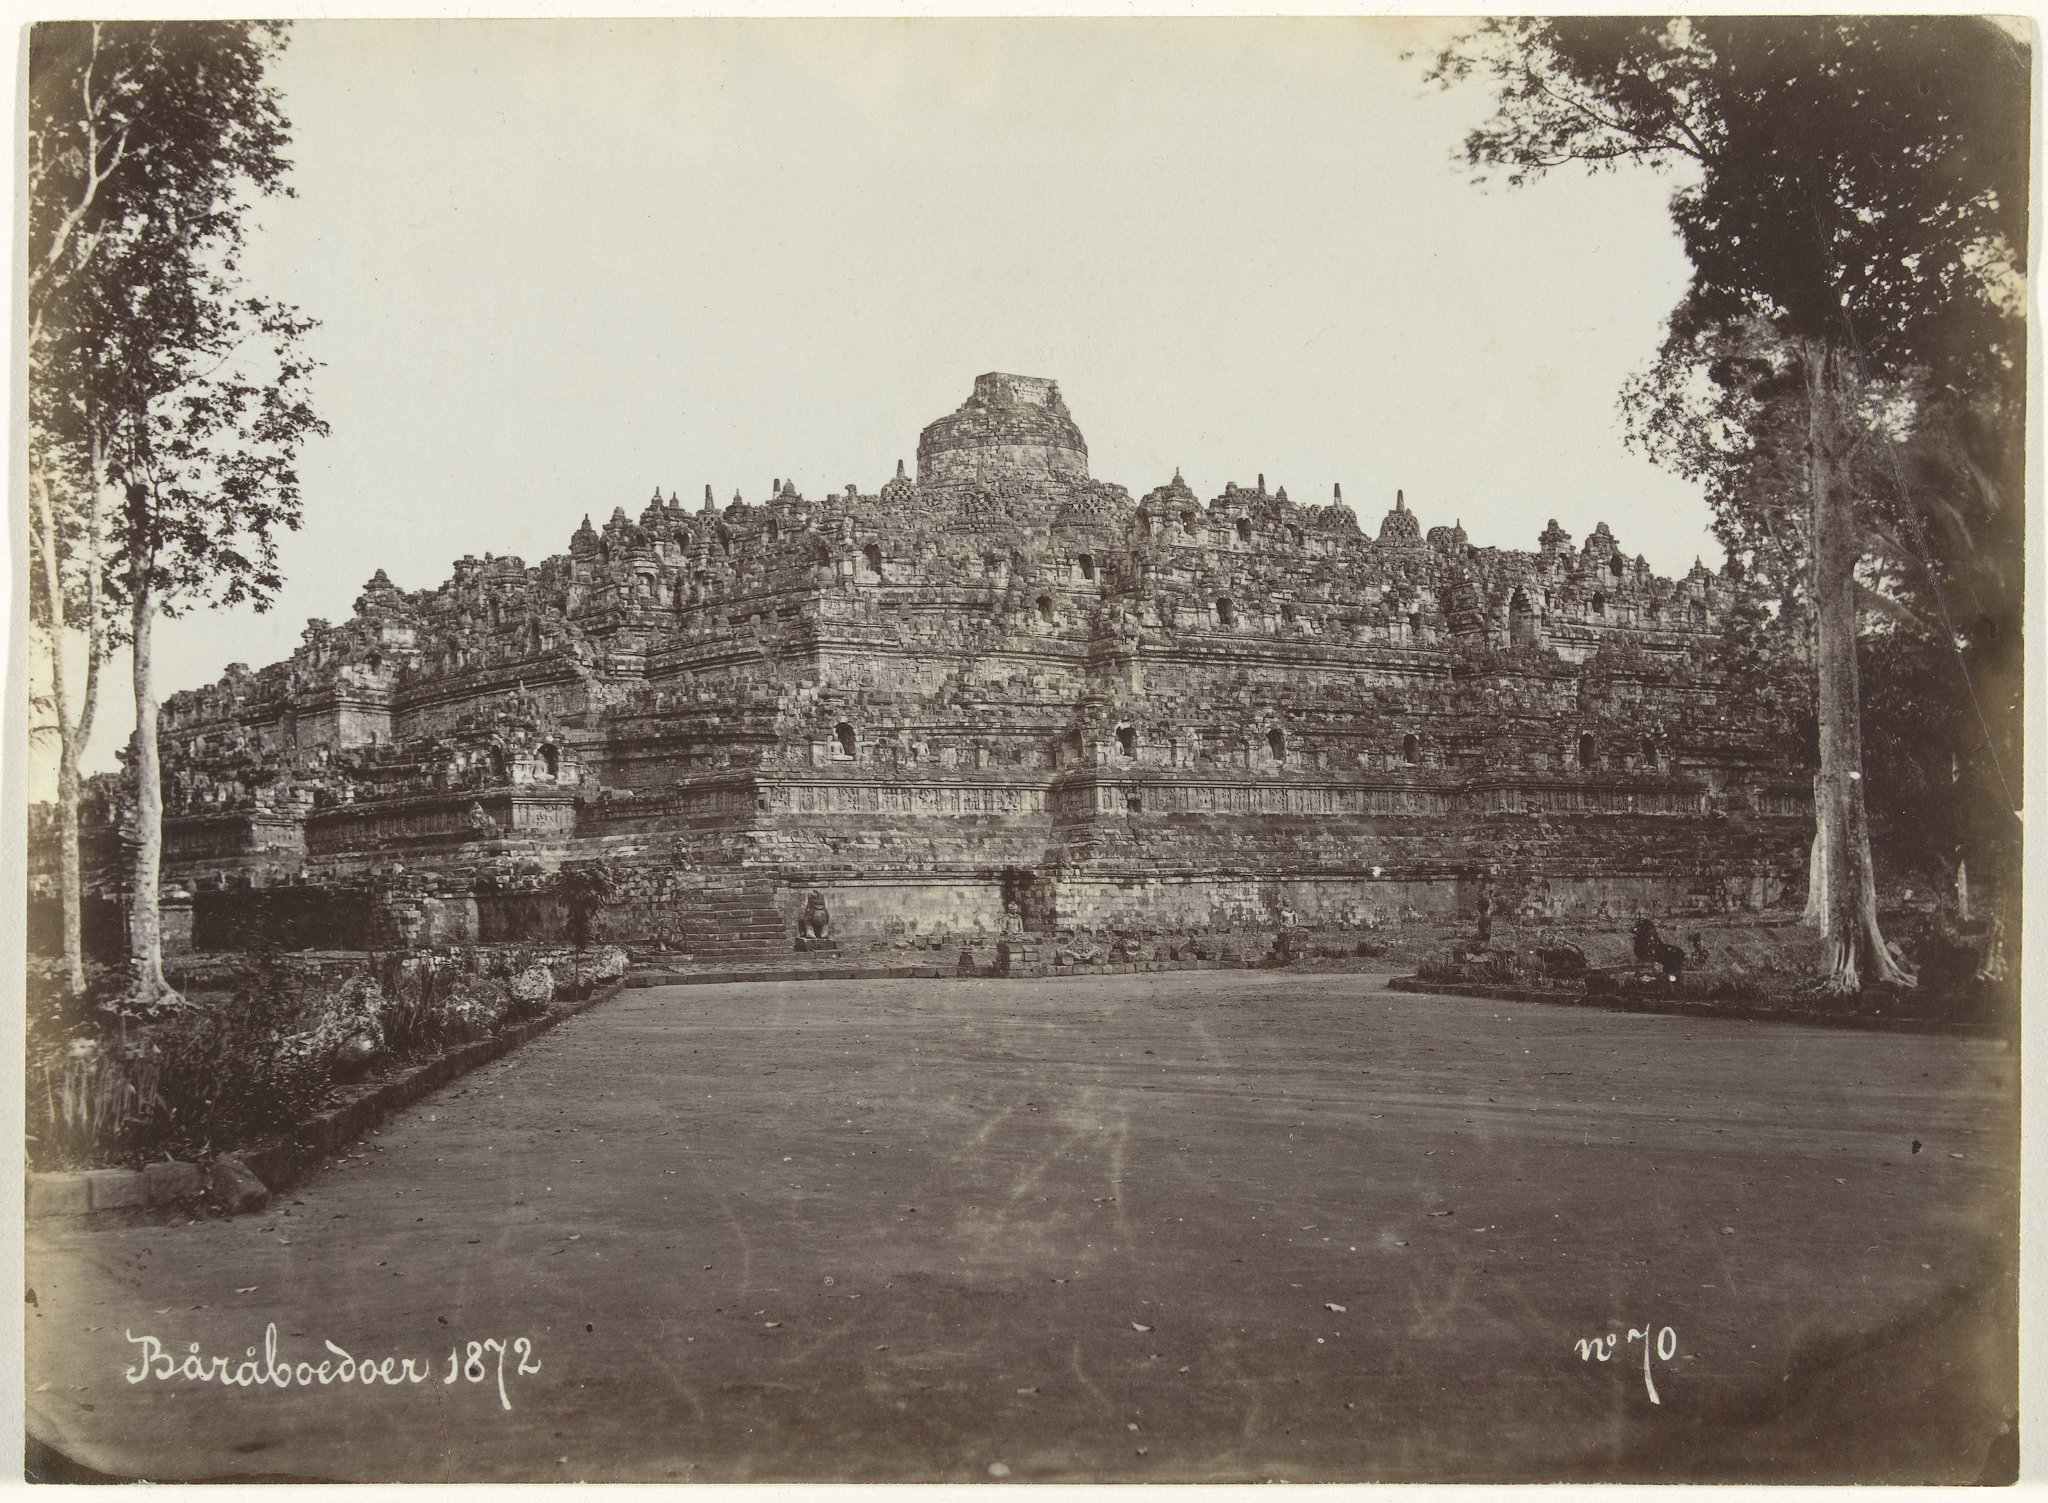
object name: photograph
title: Borobudur, gezien vanuit het noordwesten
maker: kassian céphas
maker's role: fotograaf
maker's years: 1845-1912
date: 1872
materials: paper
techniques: albumen print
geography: java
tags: temple, shrine ~ hinduism, buddhism, jainism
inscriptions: inscription: ‘Båråboedoer 1872/ no 70’